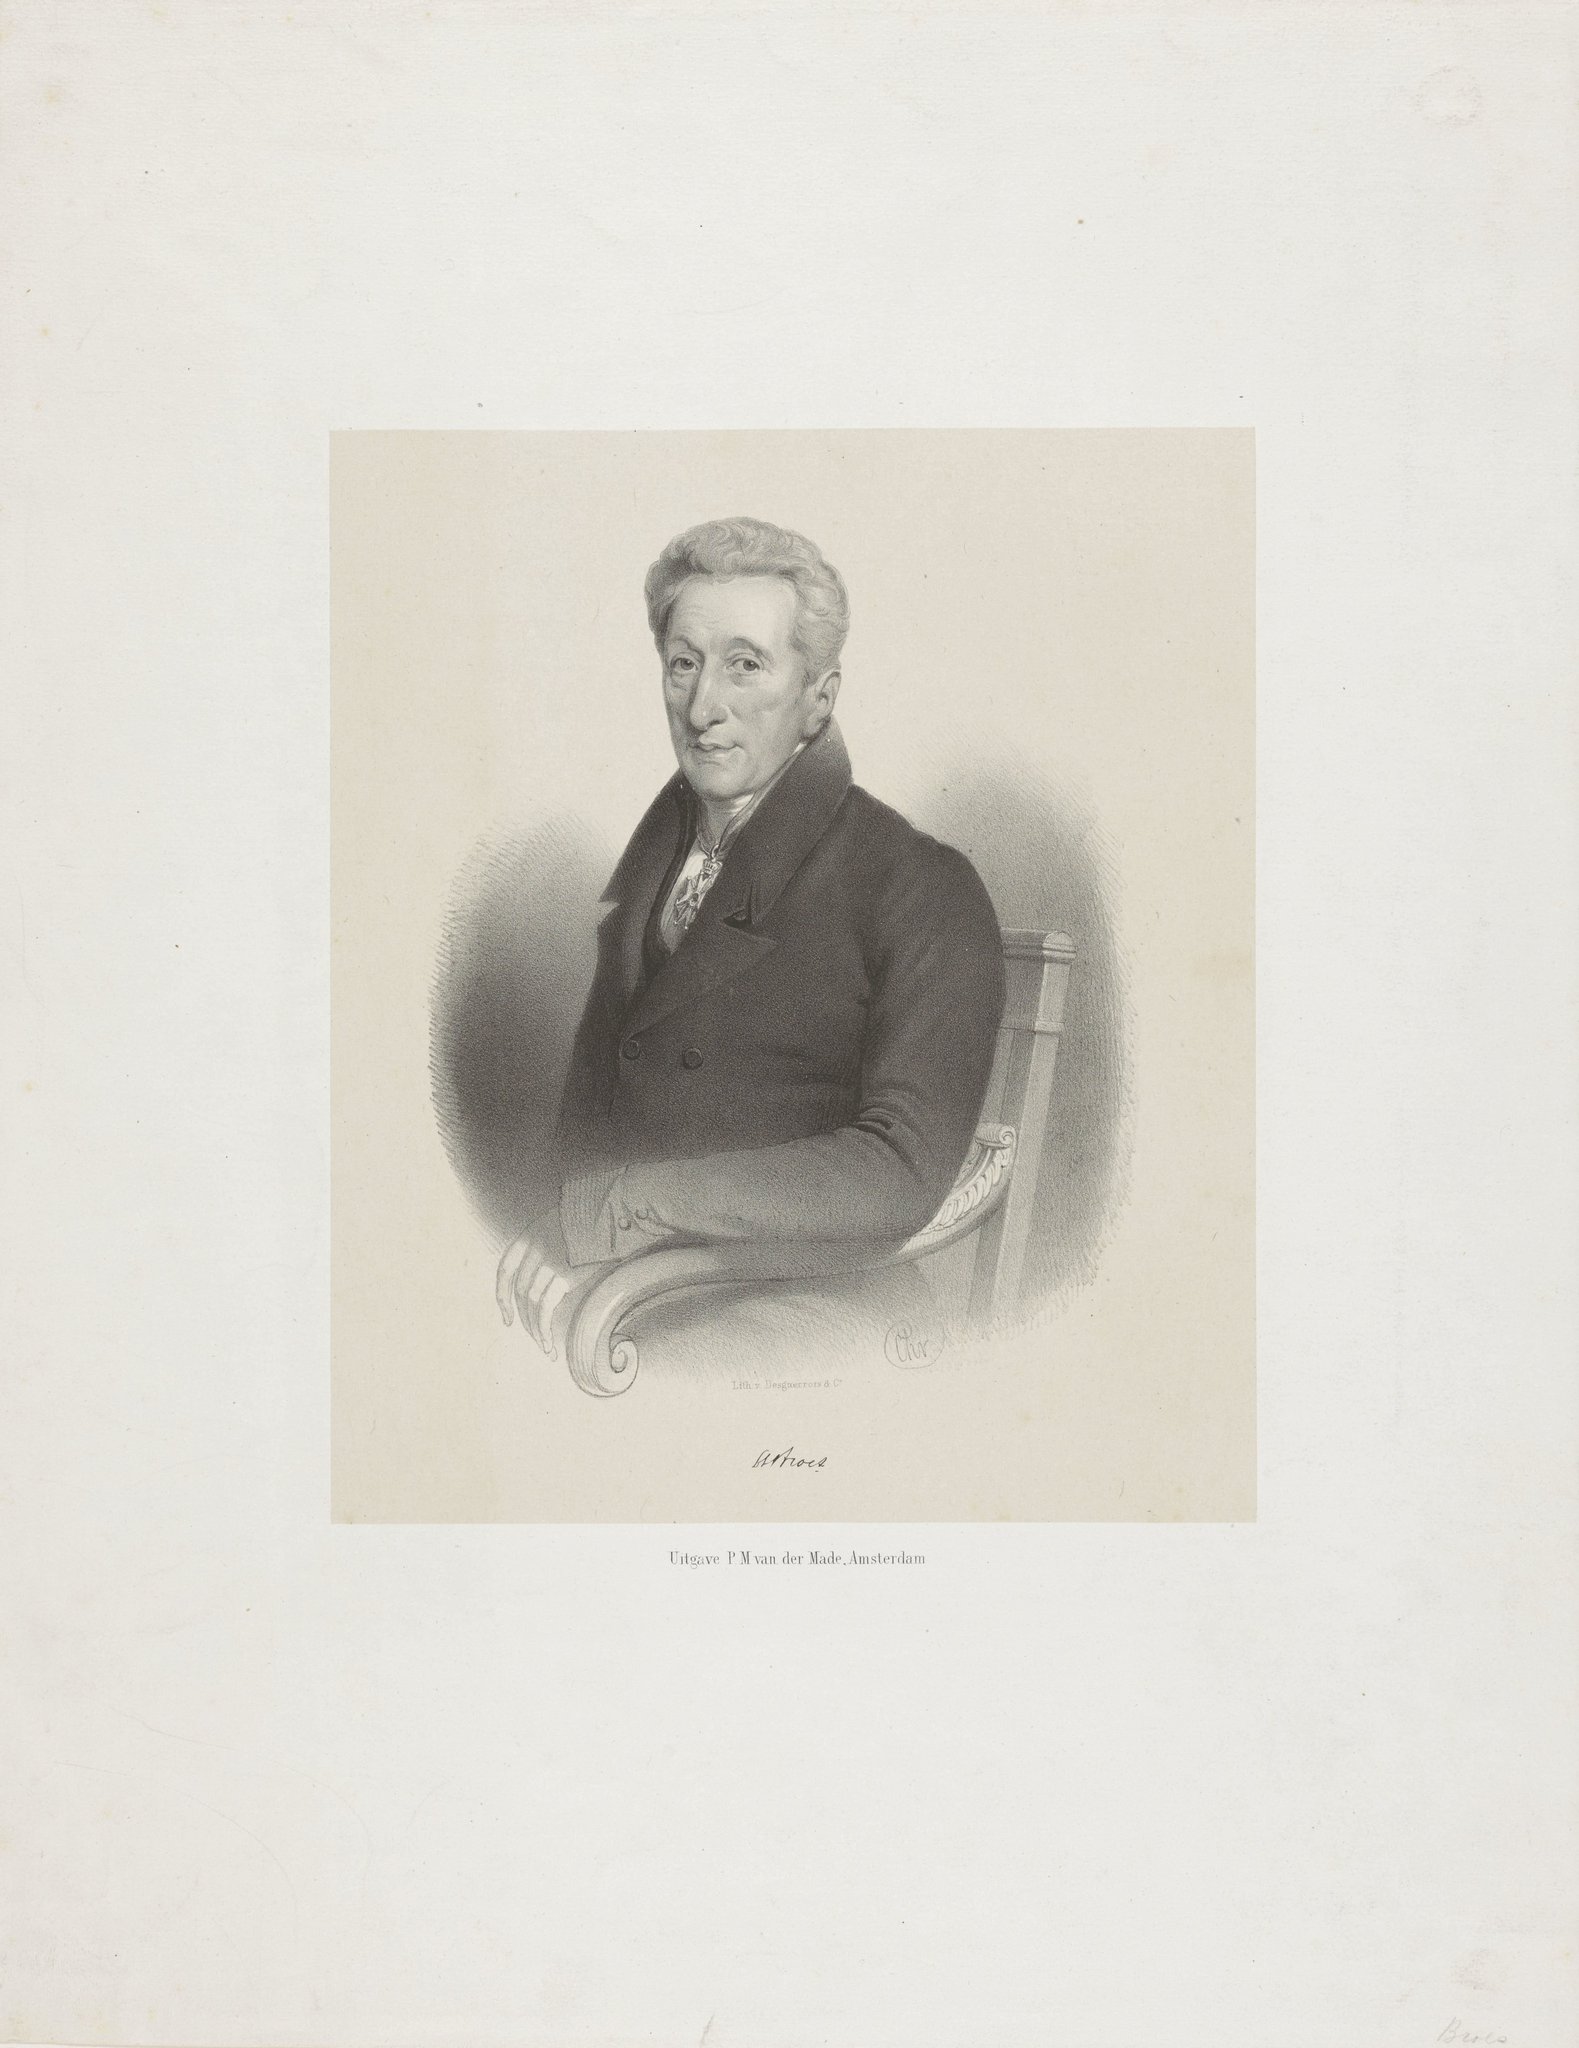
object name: print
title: Portret van een onbekende man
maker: wilhelmus cornelis chimaer van oudendorp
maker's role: print maker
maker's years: 1822-1873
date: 1857-1873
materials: paper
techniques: lithograph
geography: amsterdam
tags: knighthood order, historical persons (+ half-length portrait)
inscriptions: collector's mark: Lugt 2228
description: De man zit op een stoel, zijn linkerarm rust op de armleuning. Hij draagt een ridderorde aan een lint om zijn hals. Onder het portret zijn signatuur.